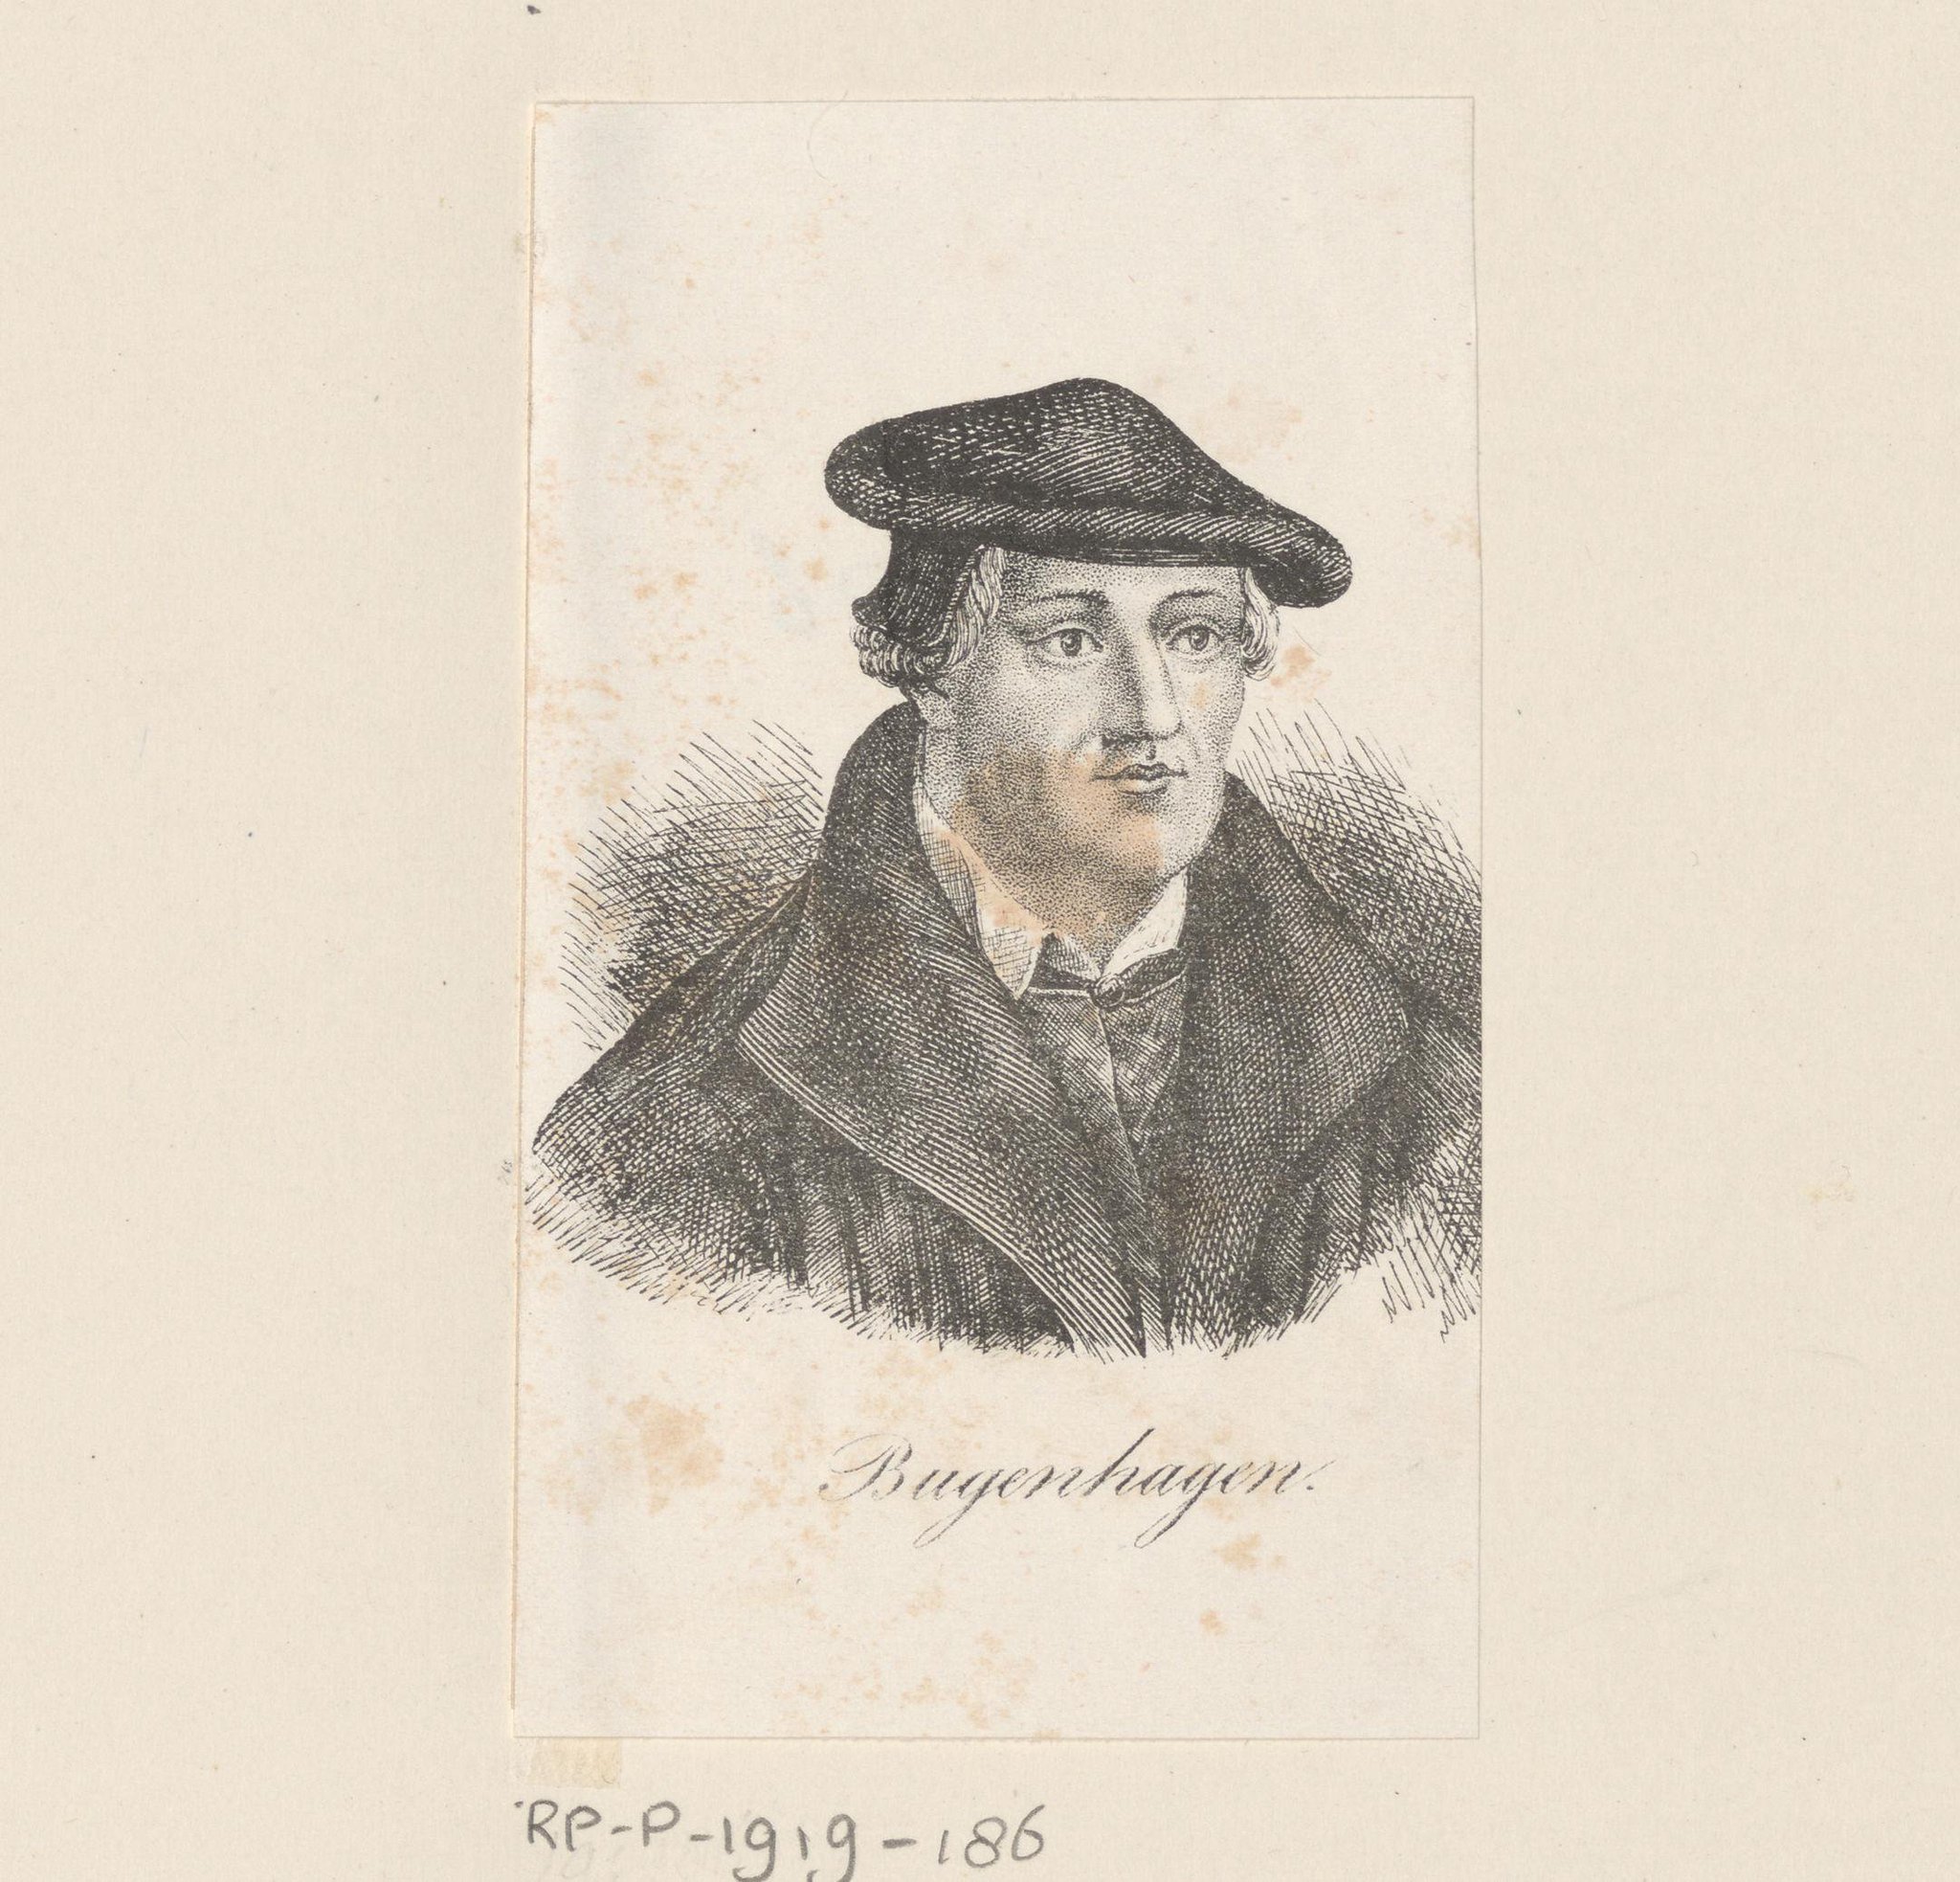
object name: print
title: Portret van Johannes Bugenhagen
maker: Anonymous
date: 1800-1849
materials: paper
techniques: lithograph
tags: theologian, historical persons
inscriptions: collector's mark: Lugt 2228